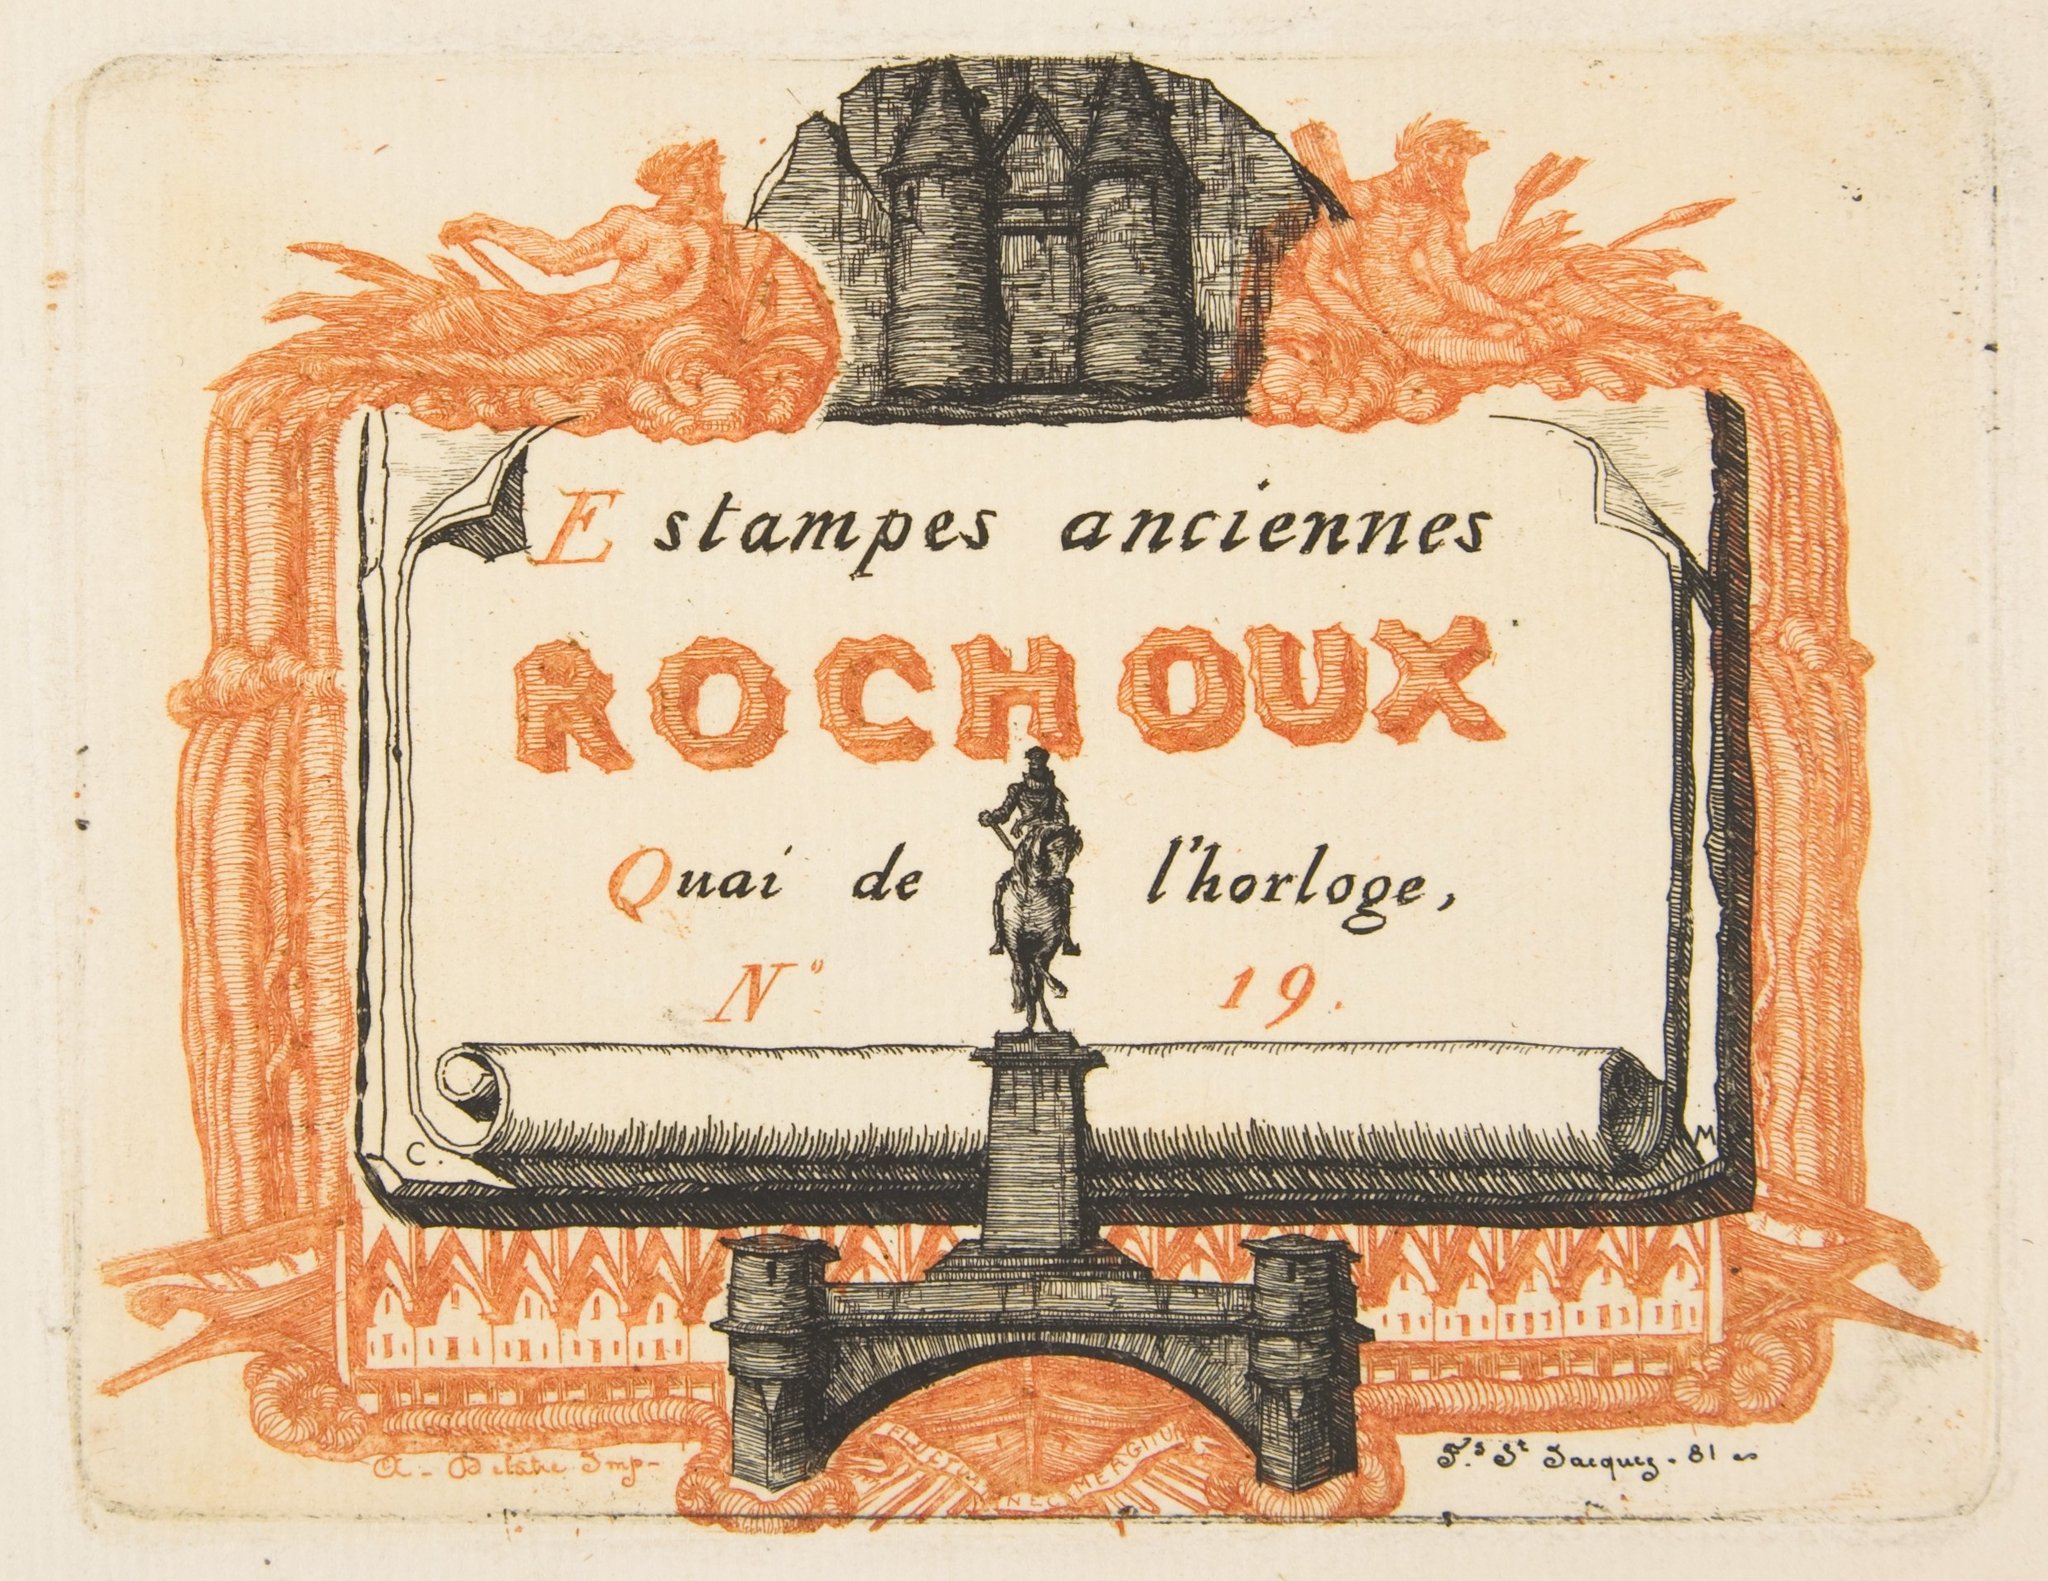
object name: print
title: Address-card of the printseller, Rochoux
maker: charles meryon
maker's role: artist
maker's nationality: french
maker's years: 1821-1868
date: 1855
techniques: etching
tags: horses